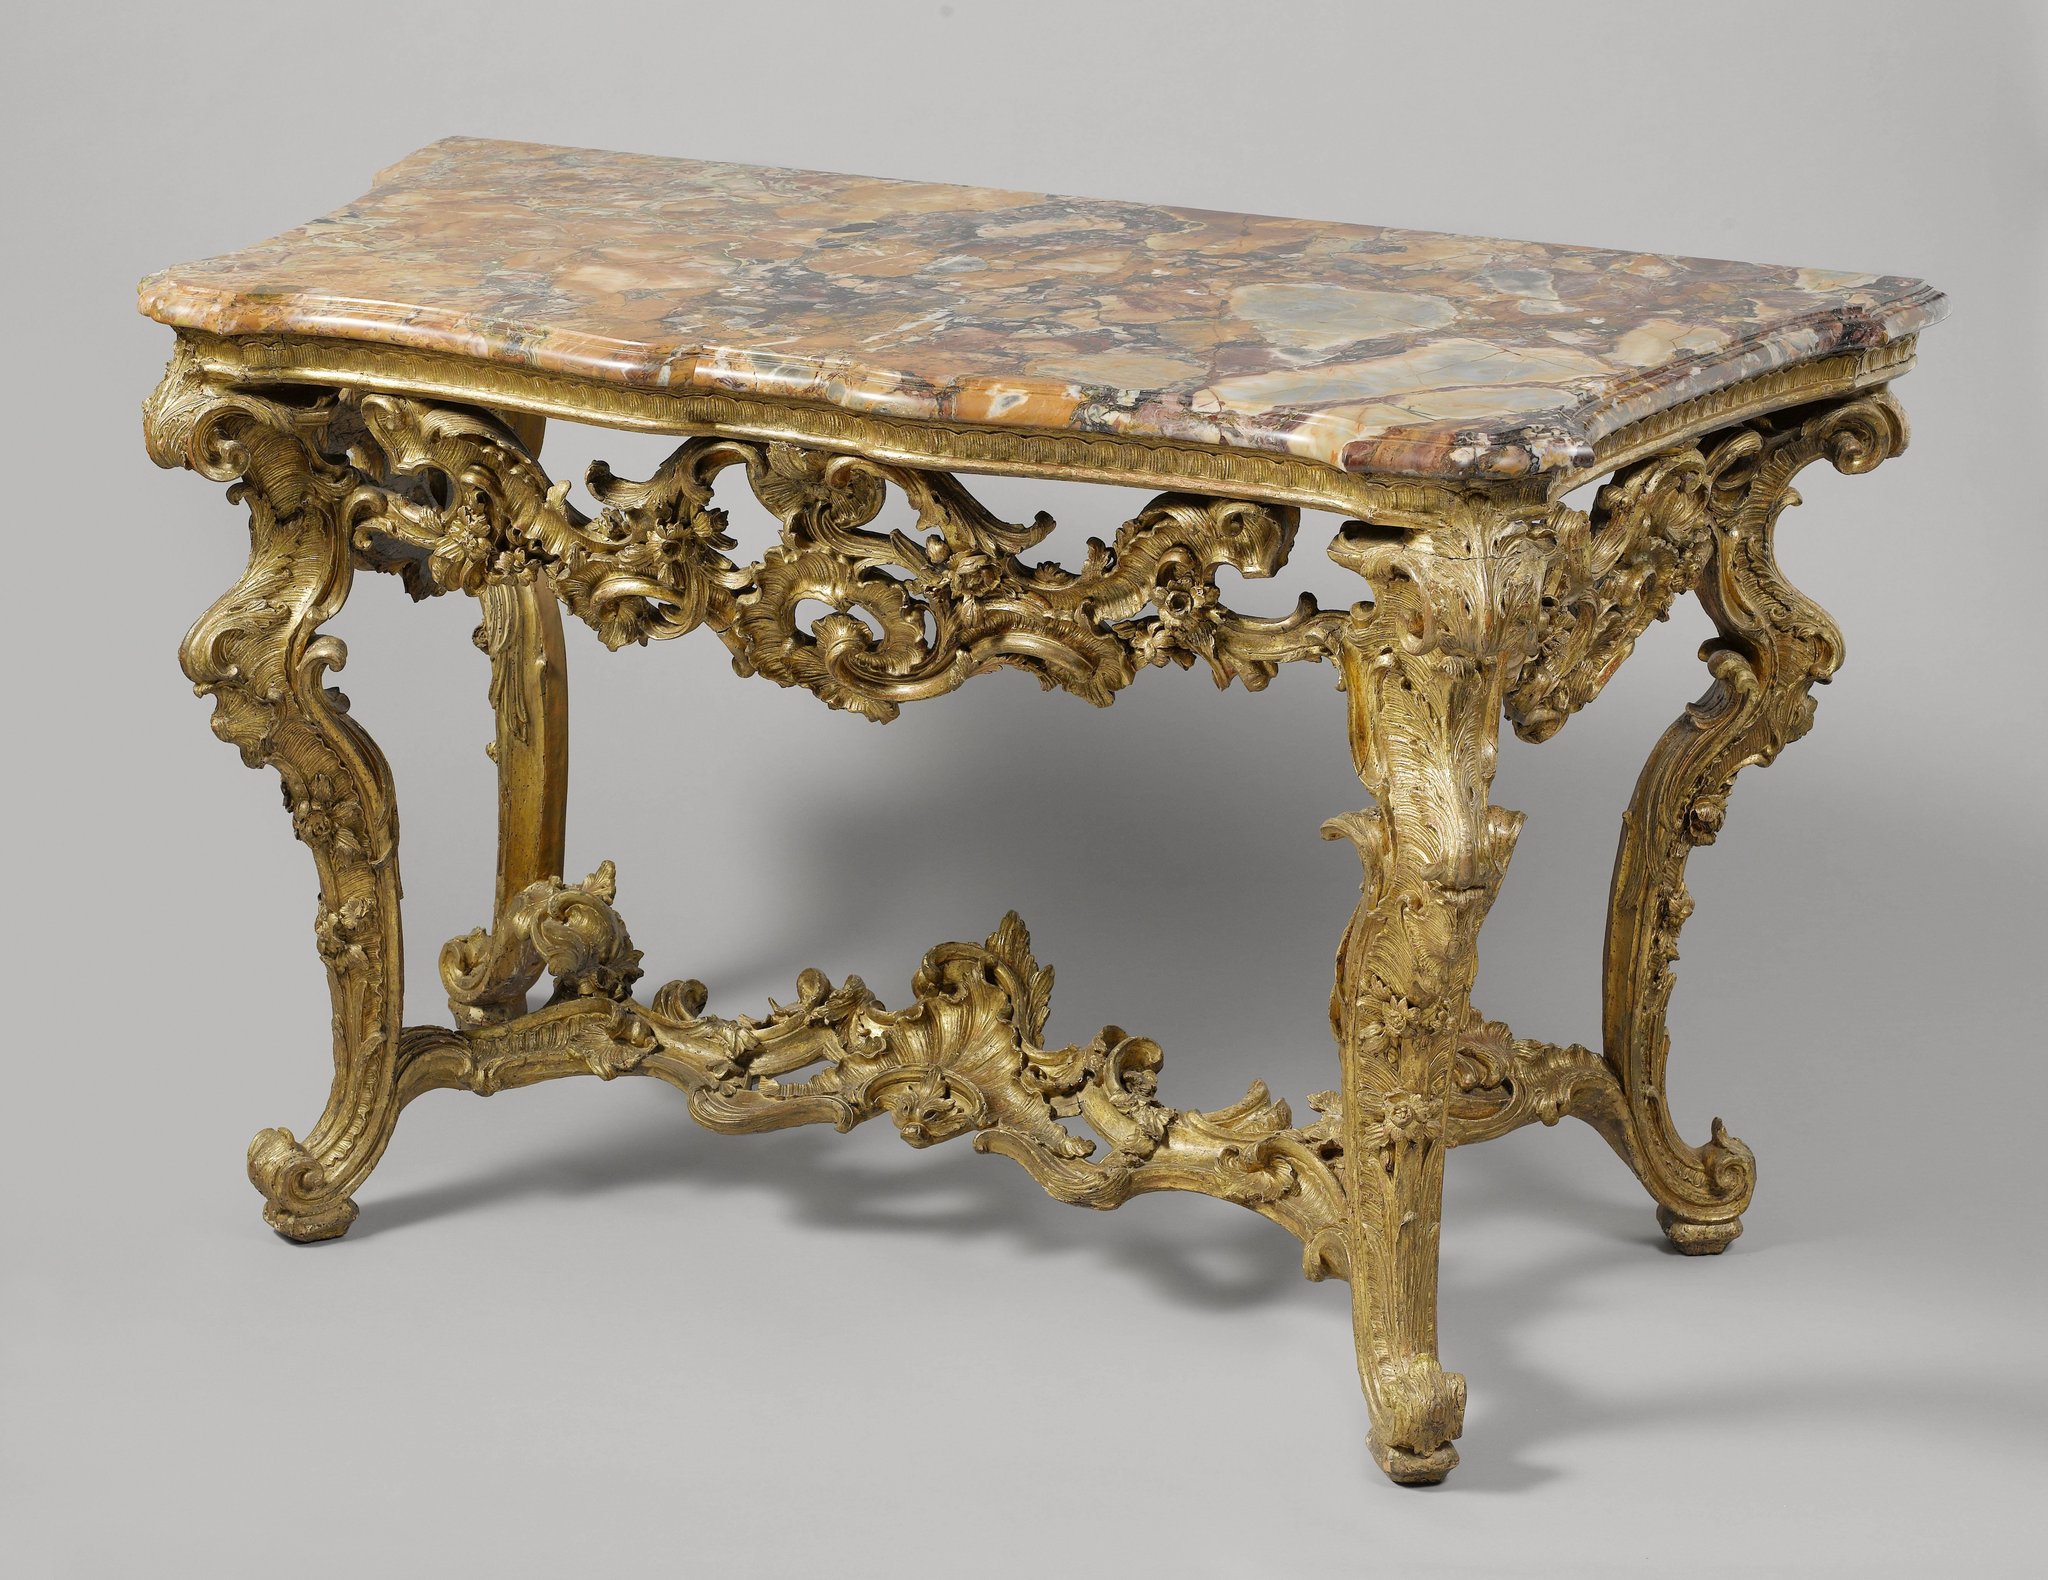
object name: furniture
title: Console table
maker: Anonymous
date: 1750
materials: wood, marble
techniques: gilding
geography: genoa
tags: rocaille ornament, acanthus ~ ornament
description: Gilded console tables were a part of the standard furnishings in the splendid formal rooms of Italian city palaces (palazzi). They were often placed below a mirror with a frame that was also gilded. By the mid-18th century, all of the Italian centres of production were embracing the French Rococo style, each city developing its own variation of it.